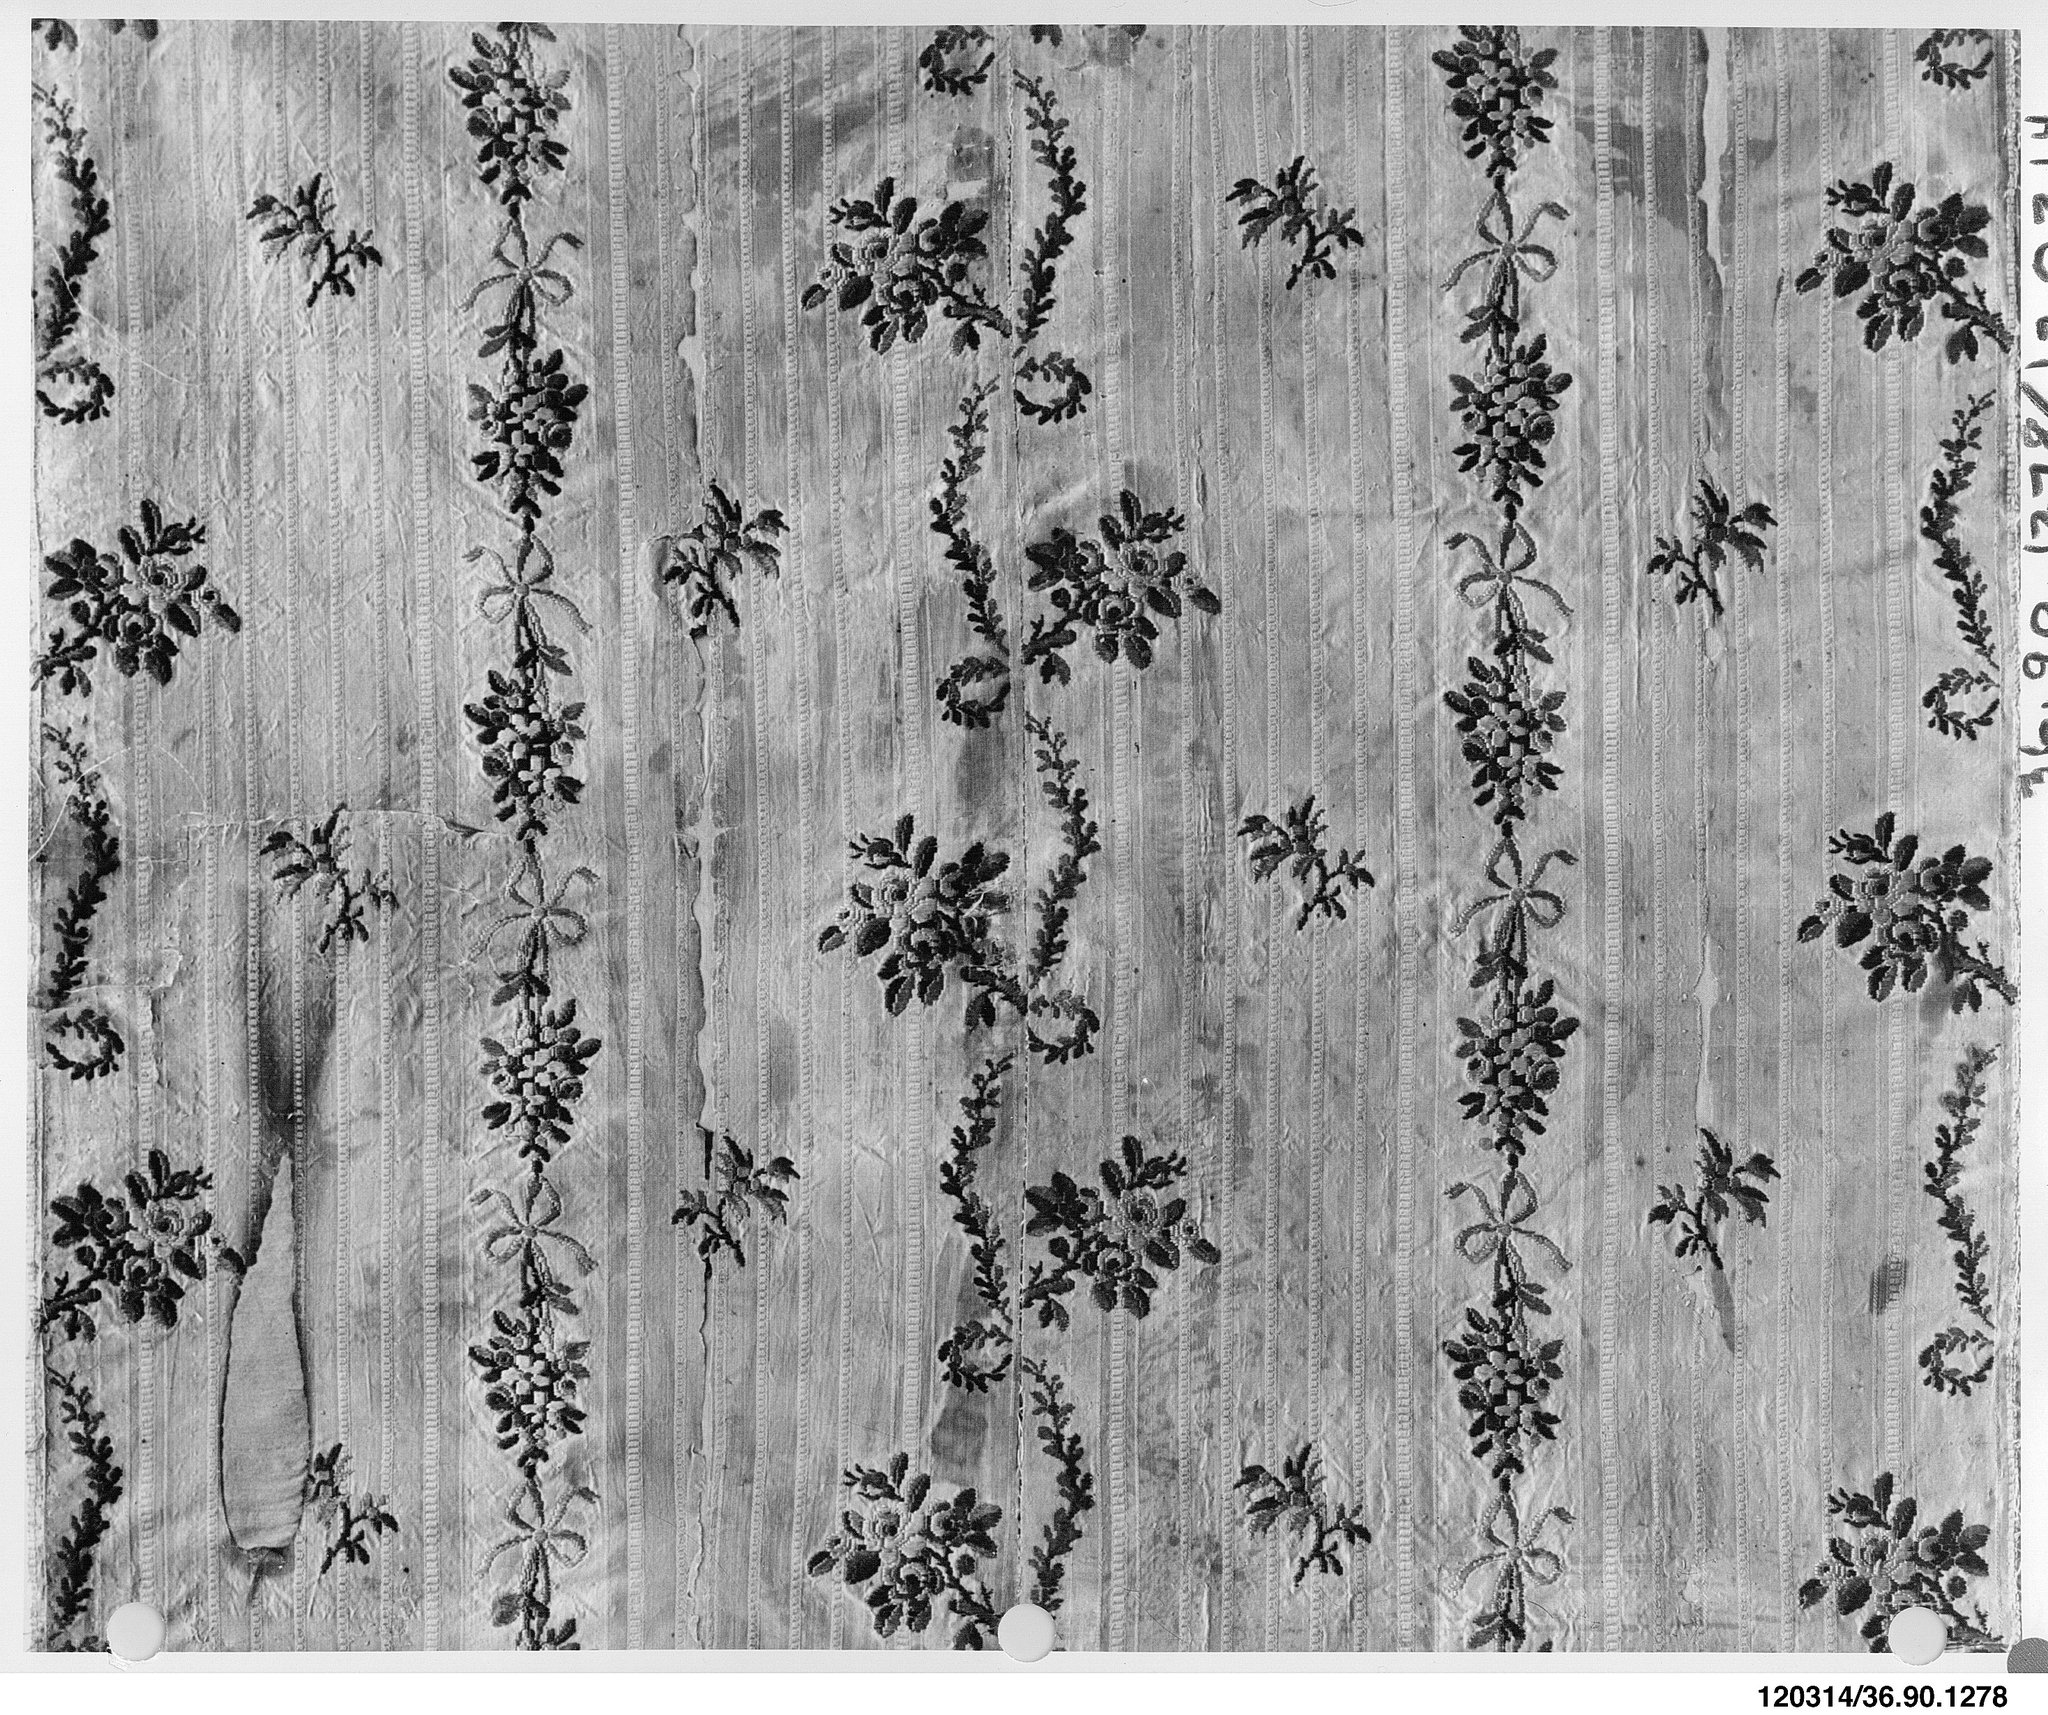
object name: piece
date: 1701-1800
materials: silk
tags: flowers,leaves